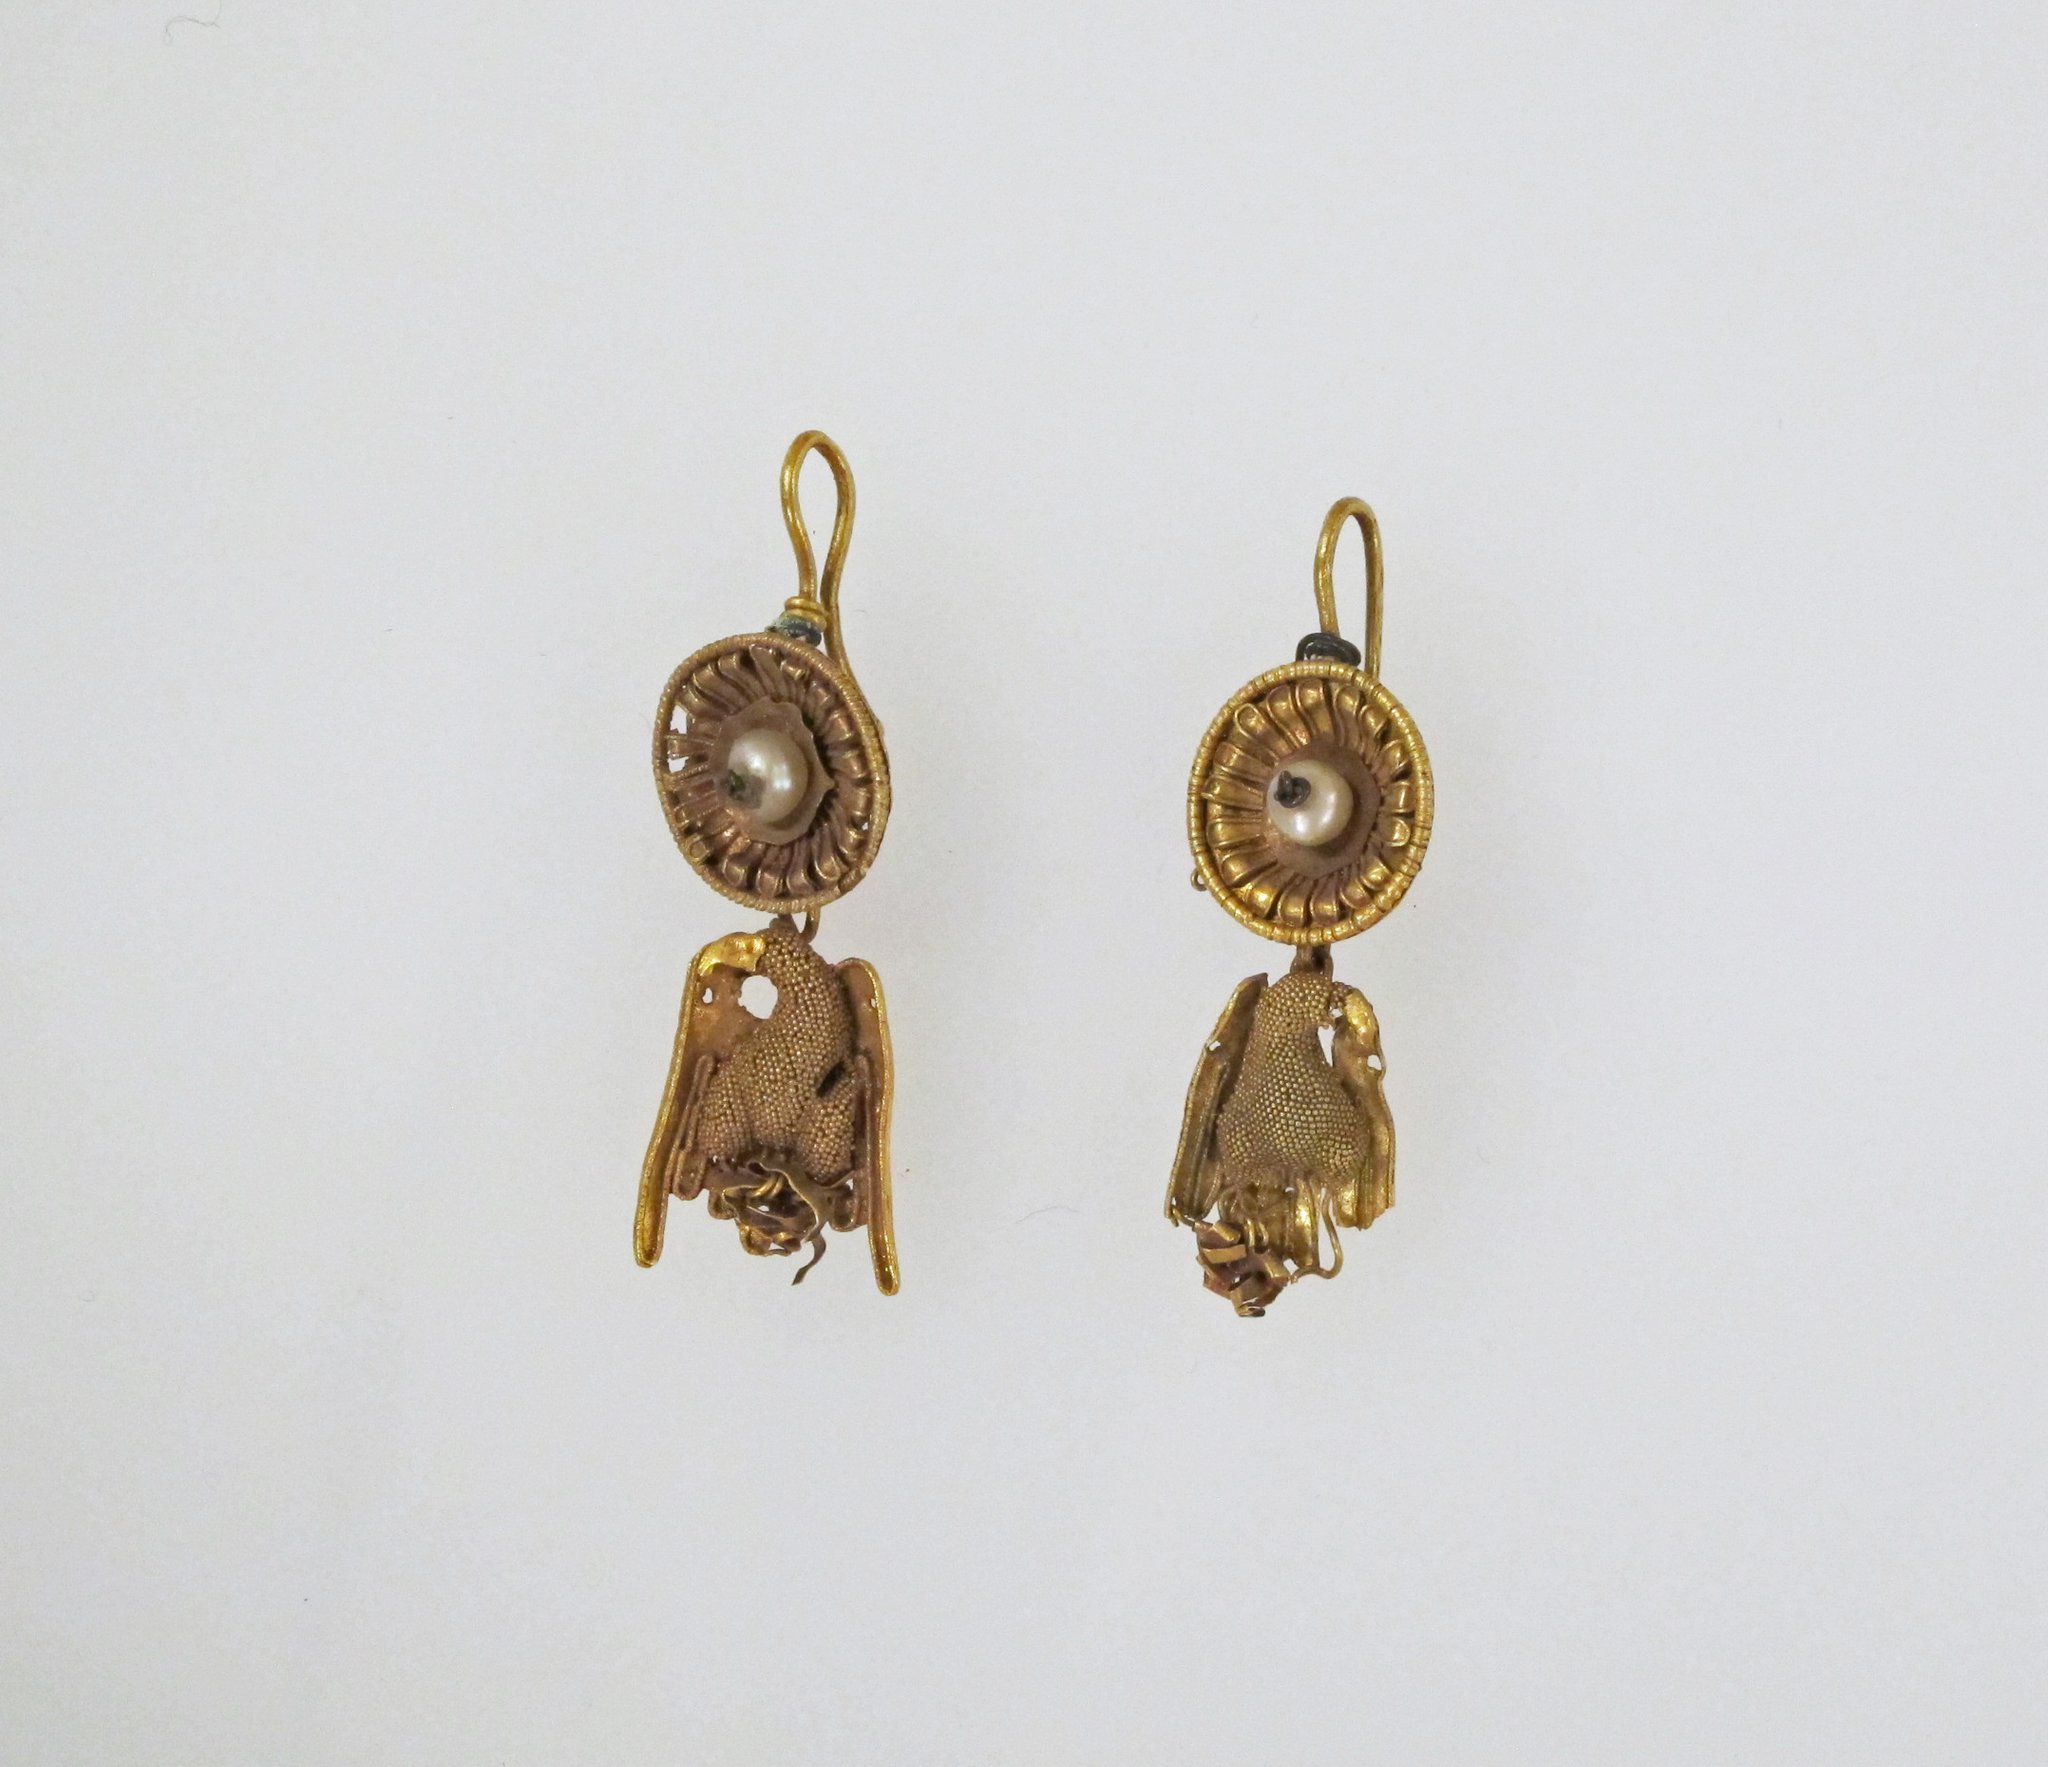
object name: earring with pendant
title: Earring with pendants and pearl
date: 300-201 BCE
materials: gold, pearl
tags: birds